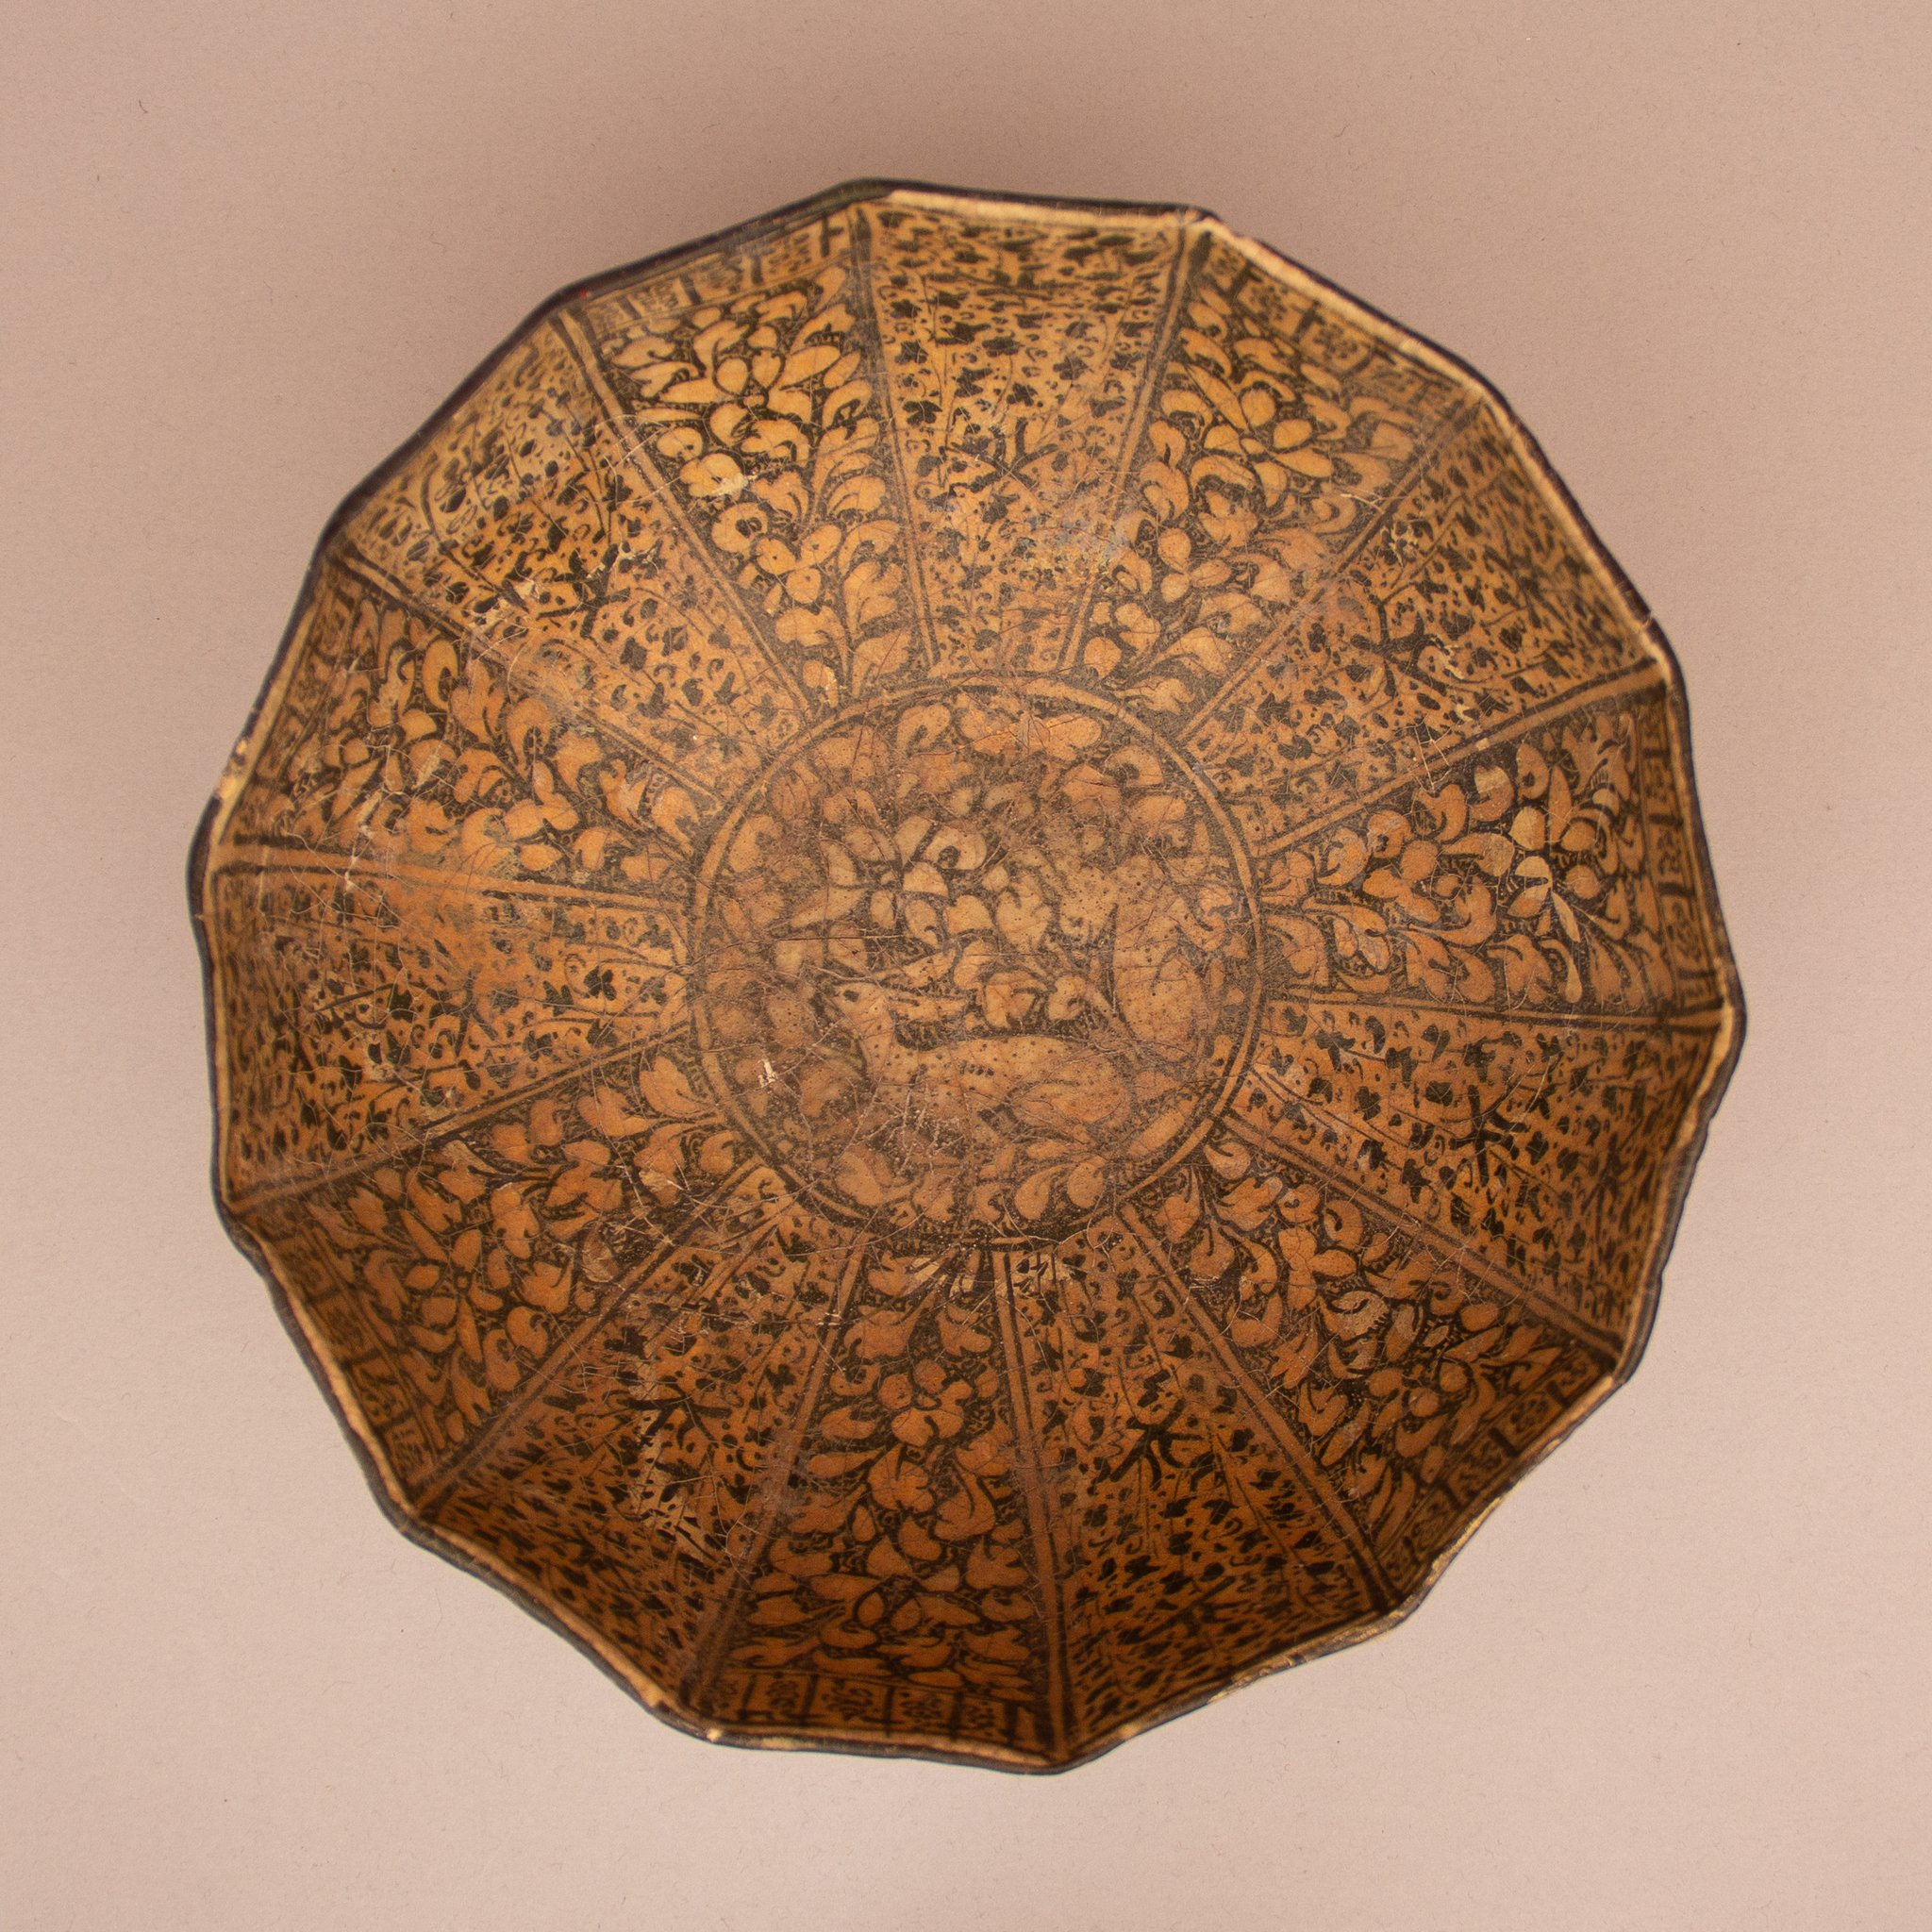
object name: bowl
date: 1301-1350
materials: stonepaste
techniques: painting, underglaze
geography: iran